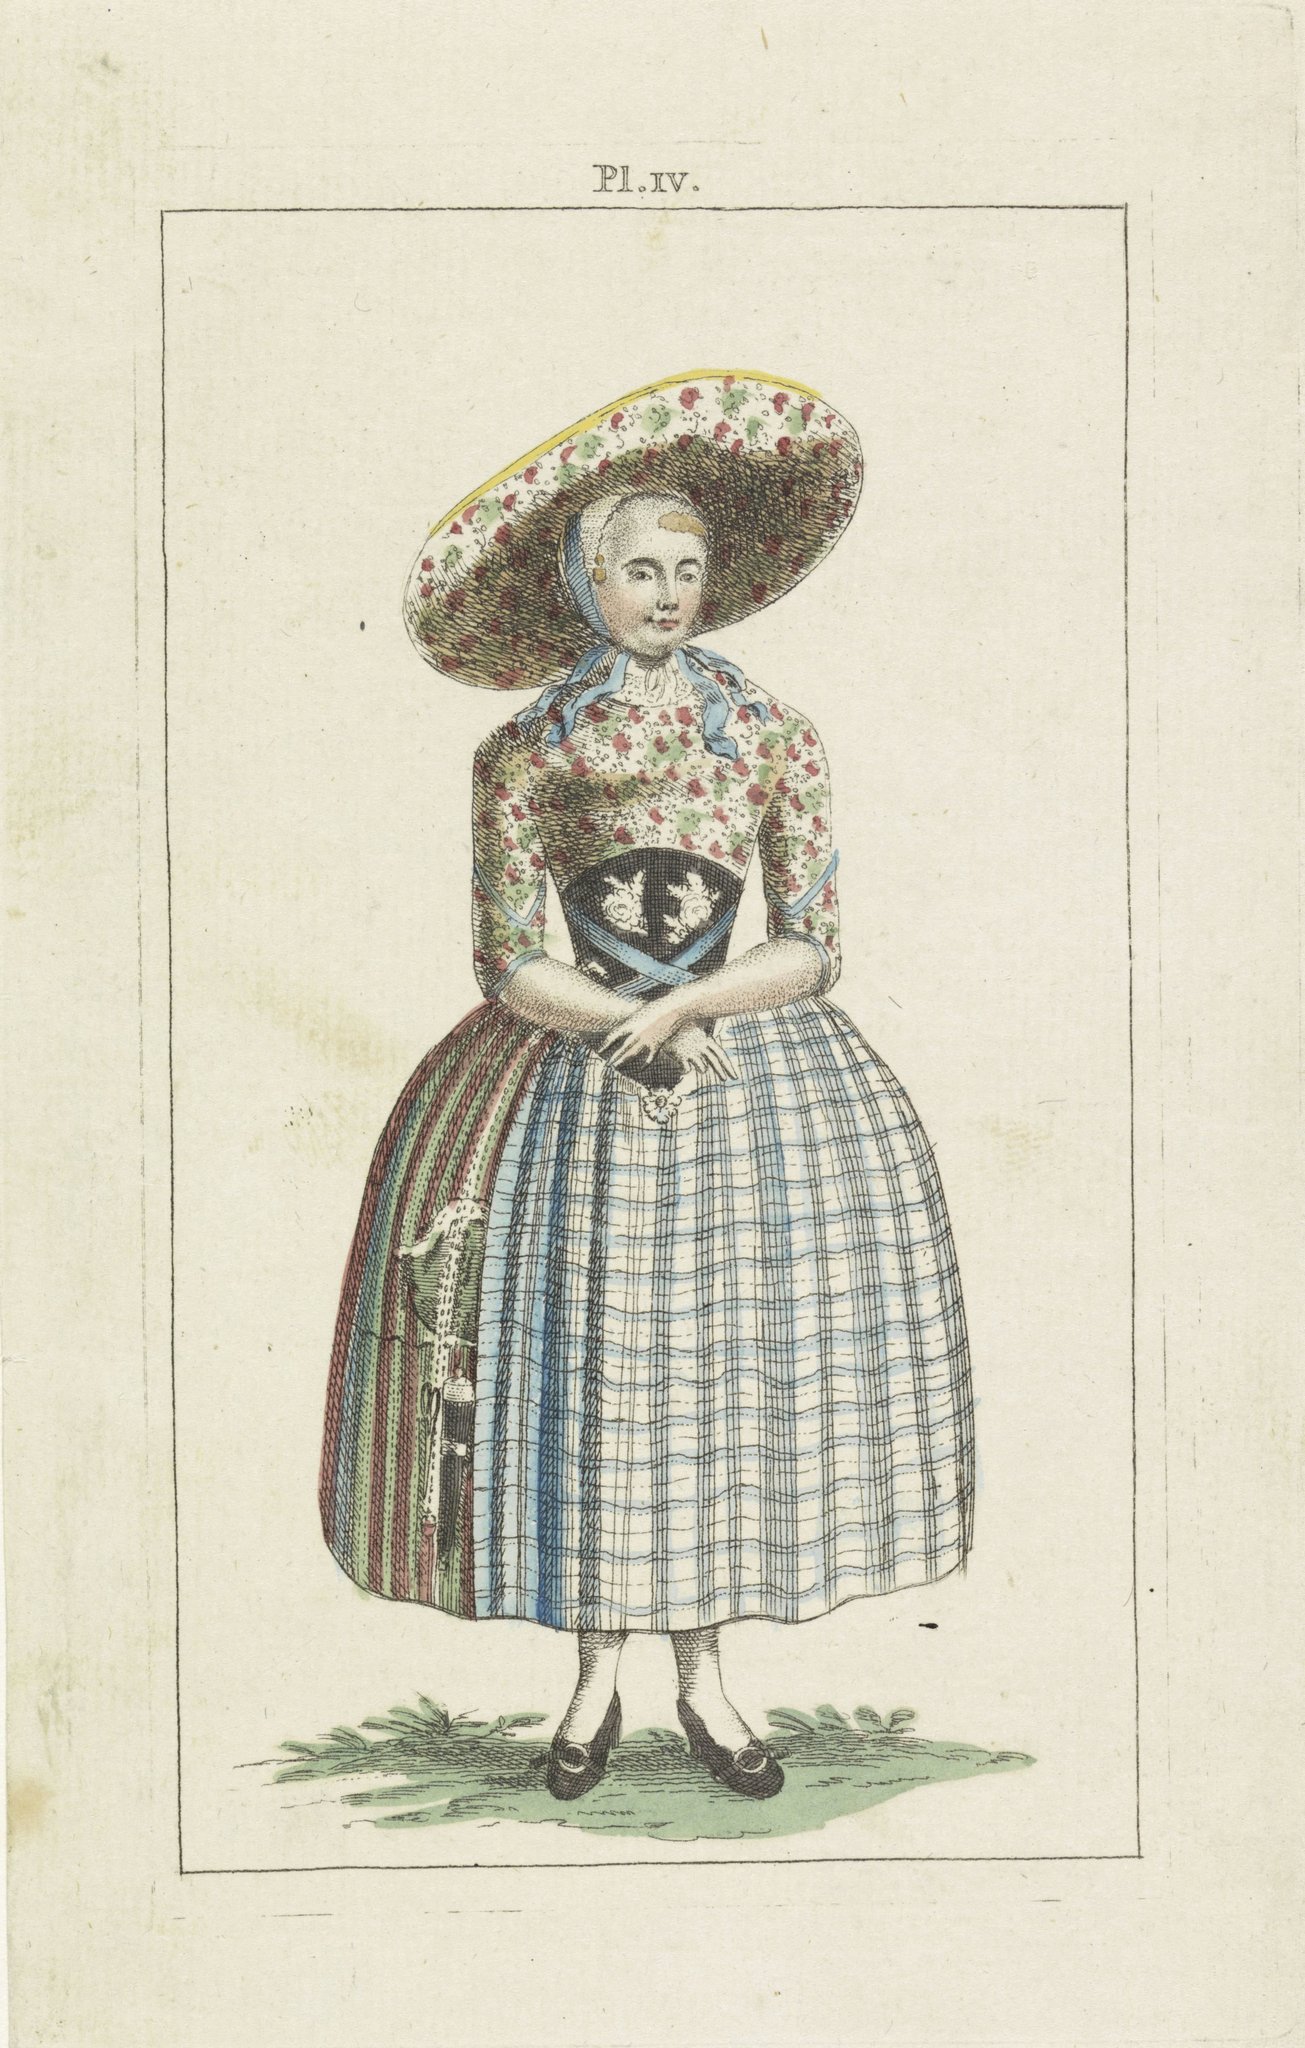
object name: print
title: Klederdracht vrouw van Zaandam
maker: Anonymous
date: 1790-1792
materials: paper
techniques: etching, hand coloring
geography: netherlands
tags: folk costume, regional costume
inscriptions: collector's mark: Lugt 2228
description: Gebruikt als illustratie in: Johann Jacob Grabner, Brieven over de Vereenigde Nederlanden. Haarlem: Adriaan Loosjes Pz., 1792.